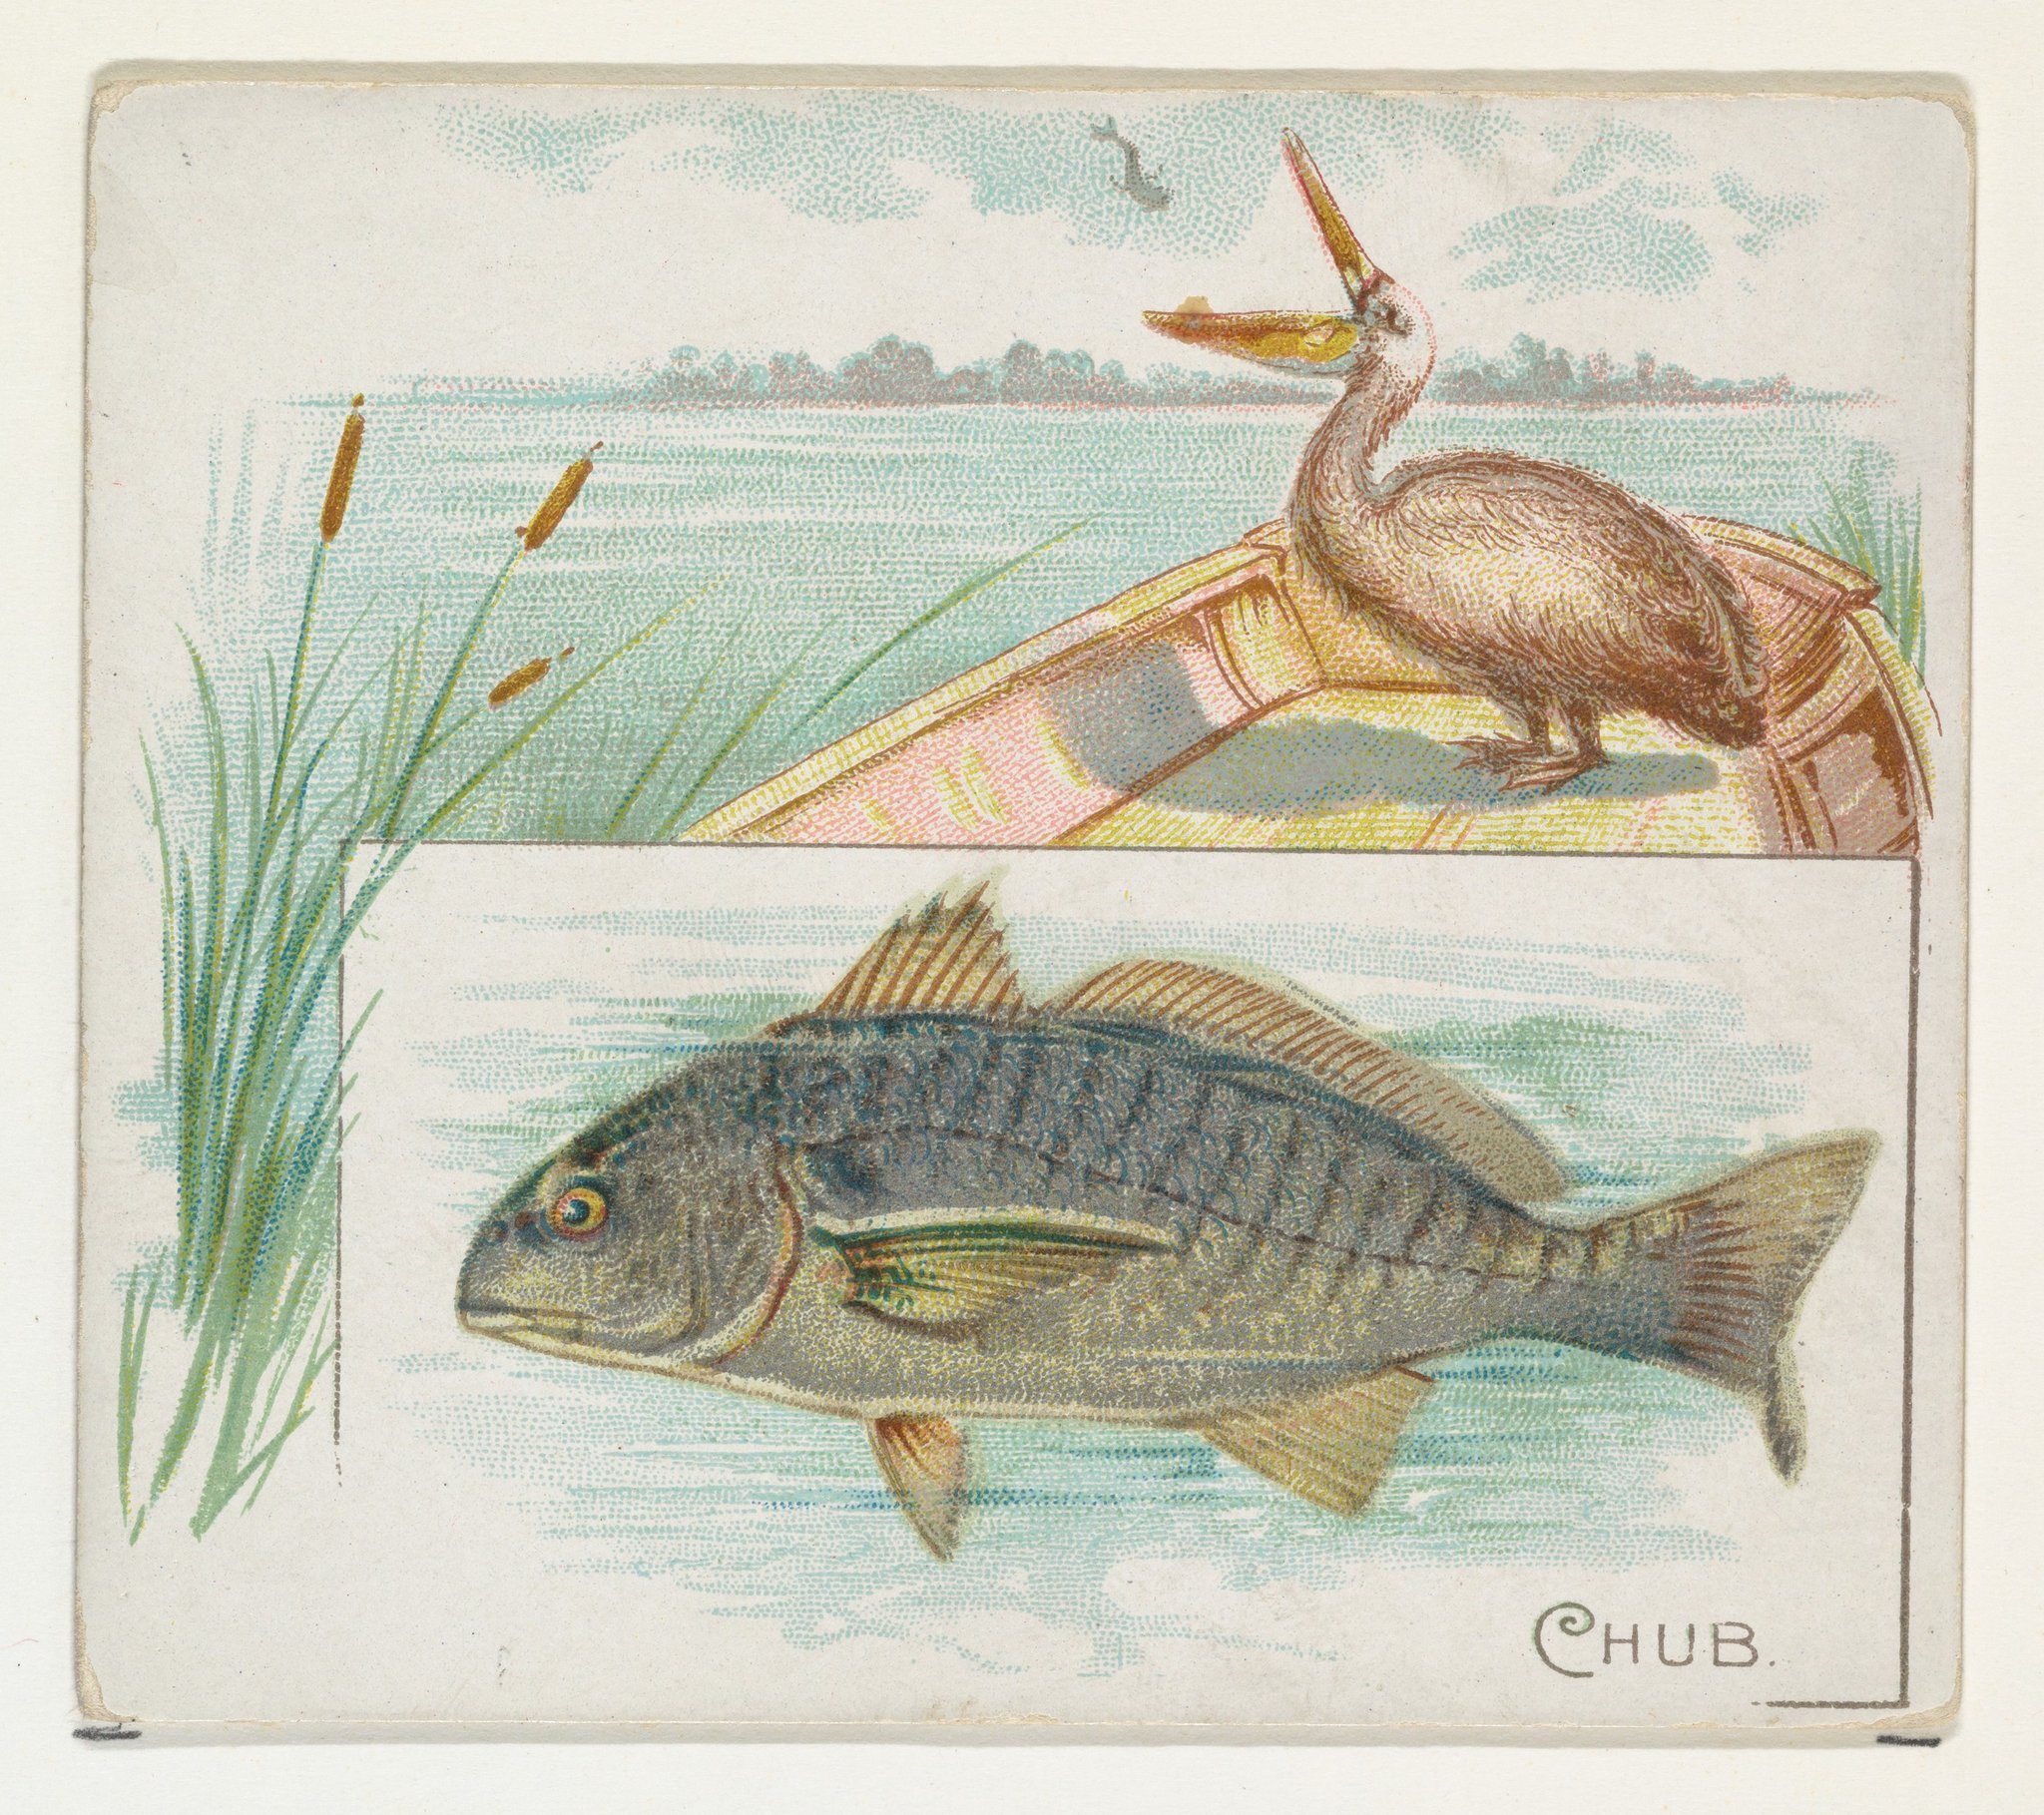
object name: print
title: Chub, from Fish from American Waters series (N39) for Allen & Ginter Cigarettes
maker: allen & ginter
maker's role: publisher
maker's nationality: american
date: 1889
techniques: color lithograph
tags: birds,fish